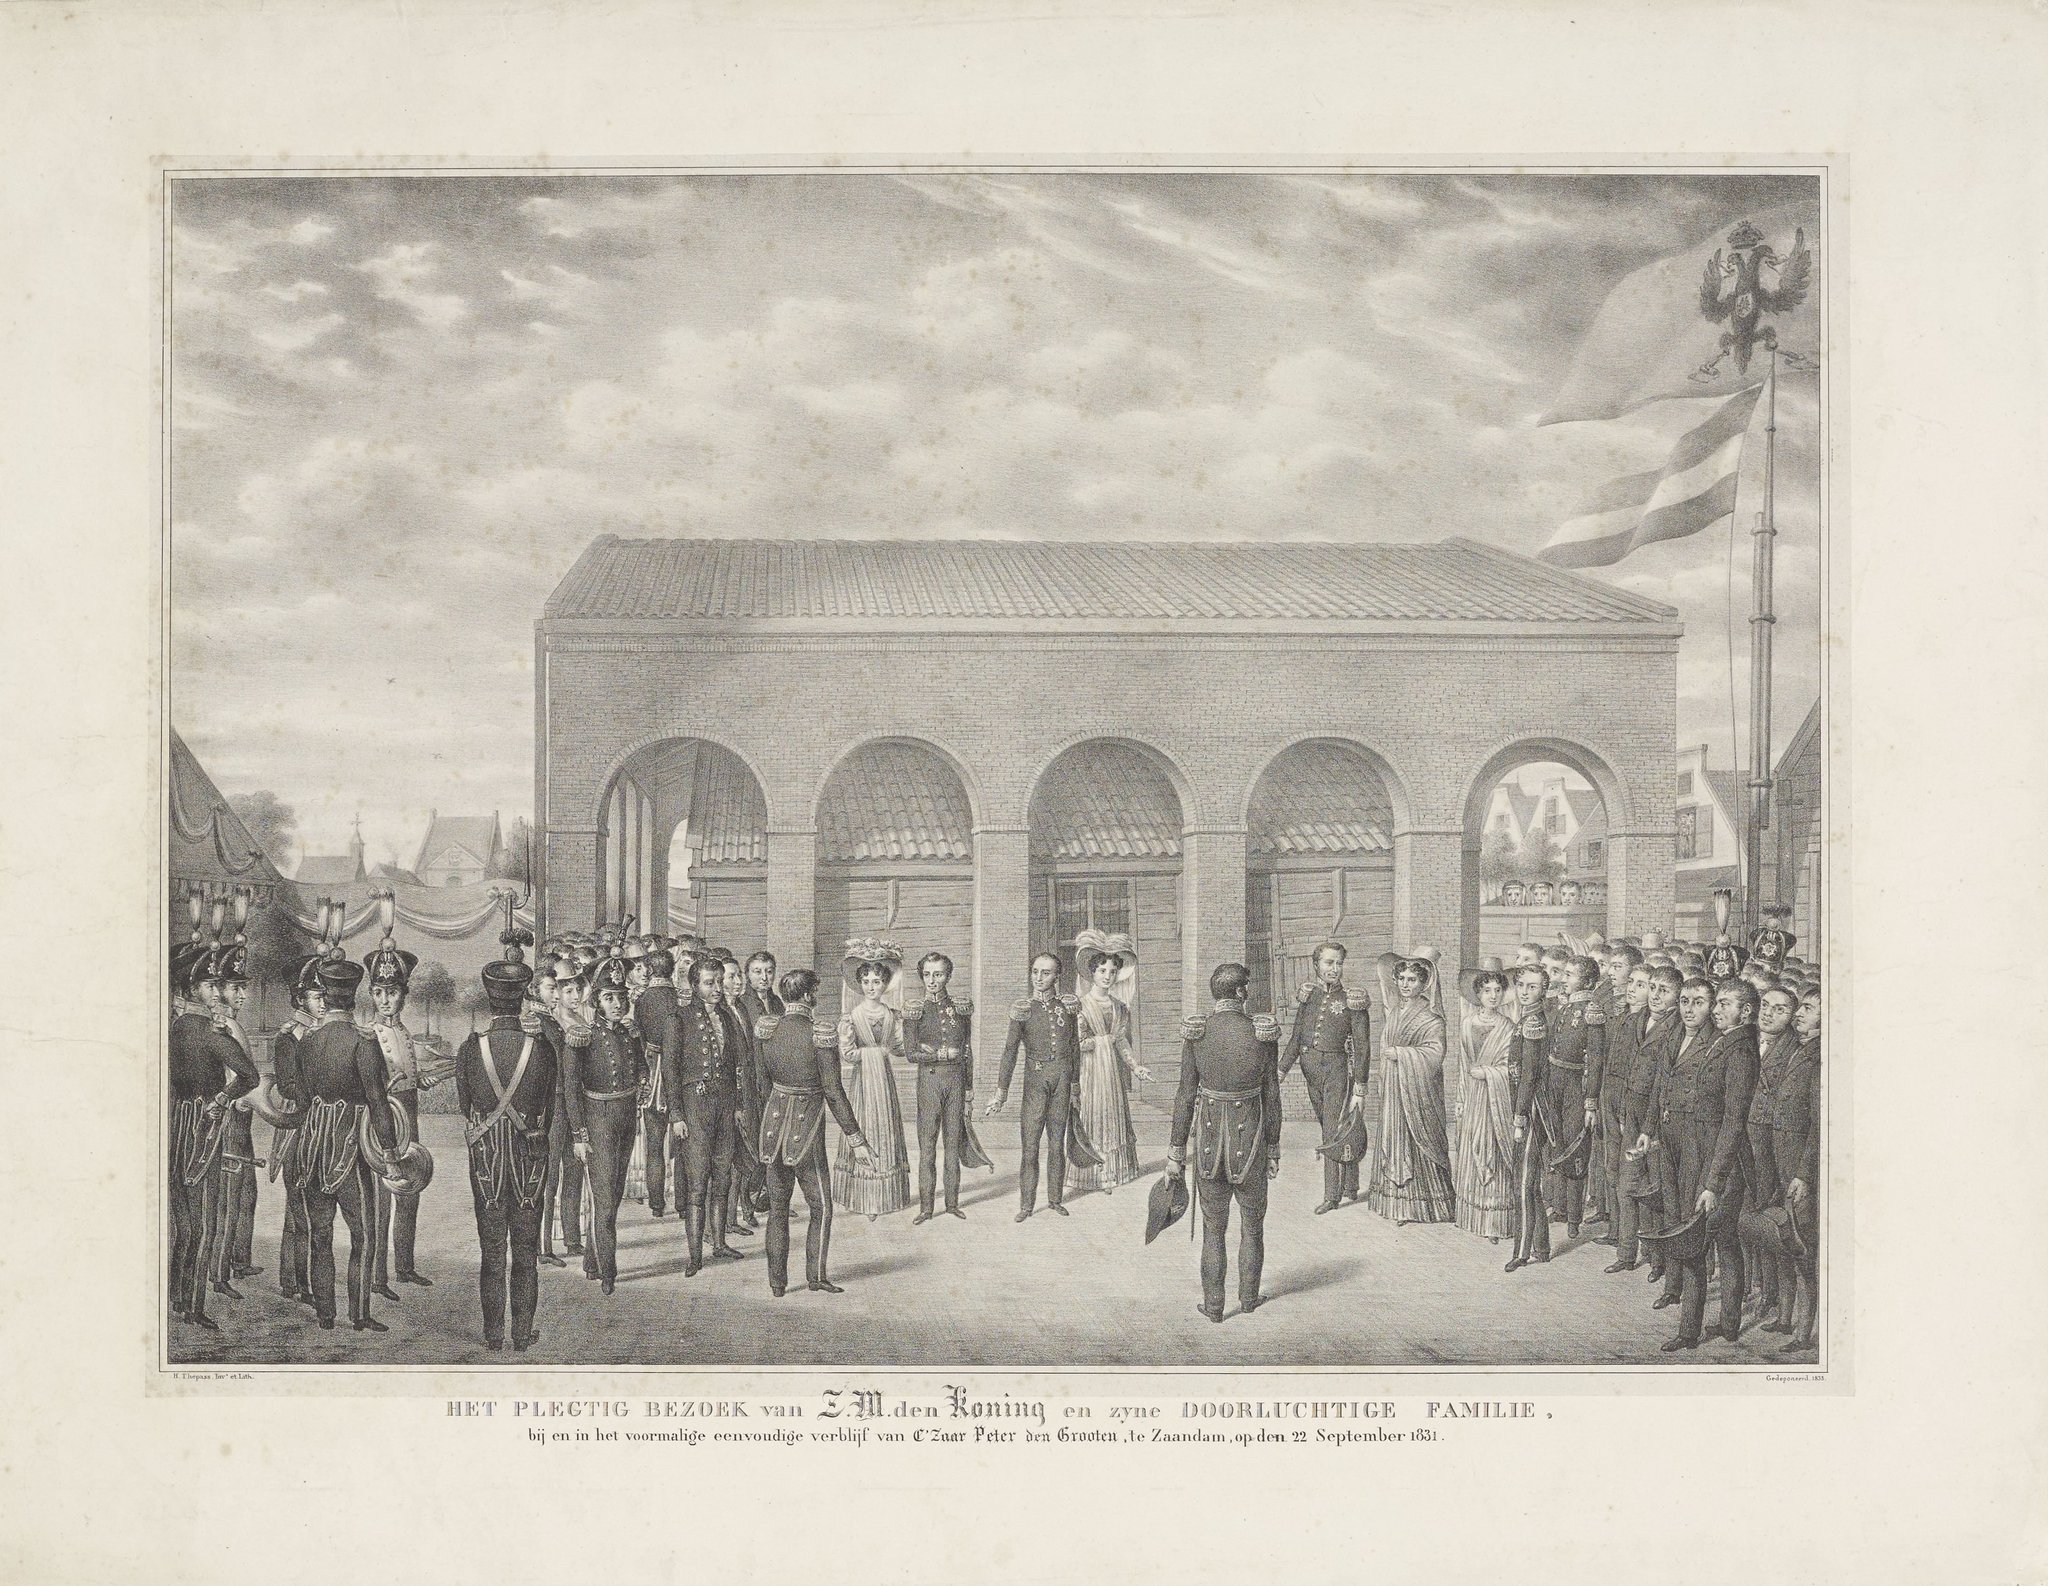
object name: print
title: Het Plegtig Bezoek van Z.M. den Koning en zyne Doorluchtige Familie, bij en in het voormalige eenvoudige verblijf van C'Zaar Peter den Grooten, te Zaandam, op den 22 September 1831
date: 1833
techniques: printmaking, lithograph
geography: netherlands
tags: anna paulowna romanowa, william i of the netherlands, william ii of the netherlands, berlin, frederik (prins der nederlanden), wilhelmina frederica louisa (koningin der nederlanden), public festivities at other royal events, not meant or mentioned above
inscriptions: collector's mark: Lugt 2228, : ‘Gedeponeerd. 1833’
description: Bezoek van koning Willem I met zijn familie aan het voor een bezoek aan het Tsaar Peterhuisje te Zaandam op 22 sepetember 1831. Het gezelschap met de koning en koningin en de twee prinsen met hun vrouwen staande voor het huis.